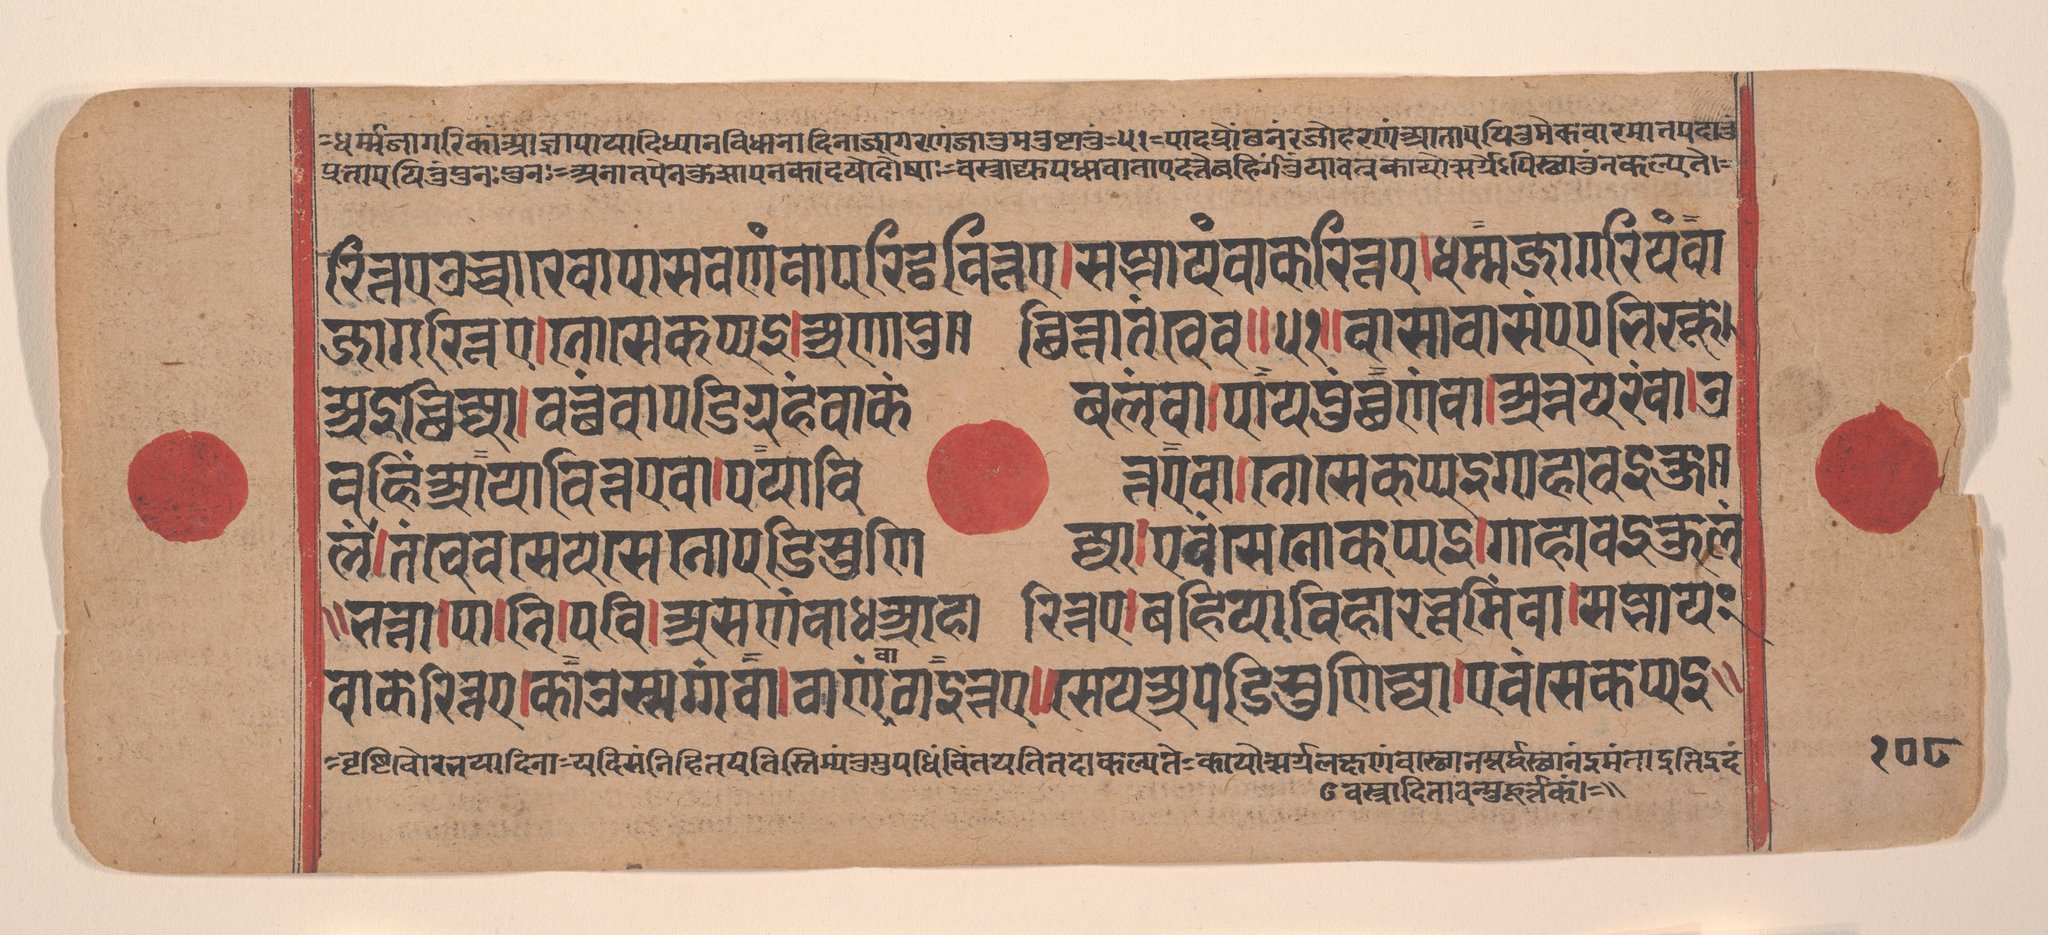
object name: folio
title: Page from a Dispersed Kalpa Sutra (Jain Book of Rituals)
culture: indian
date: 1401-1500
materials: gold, ink, paper, watercolor